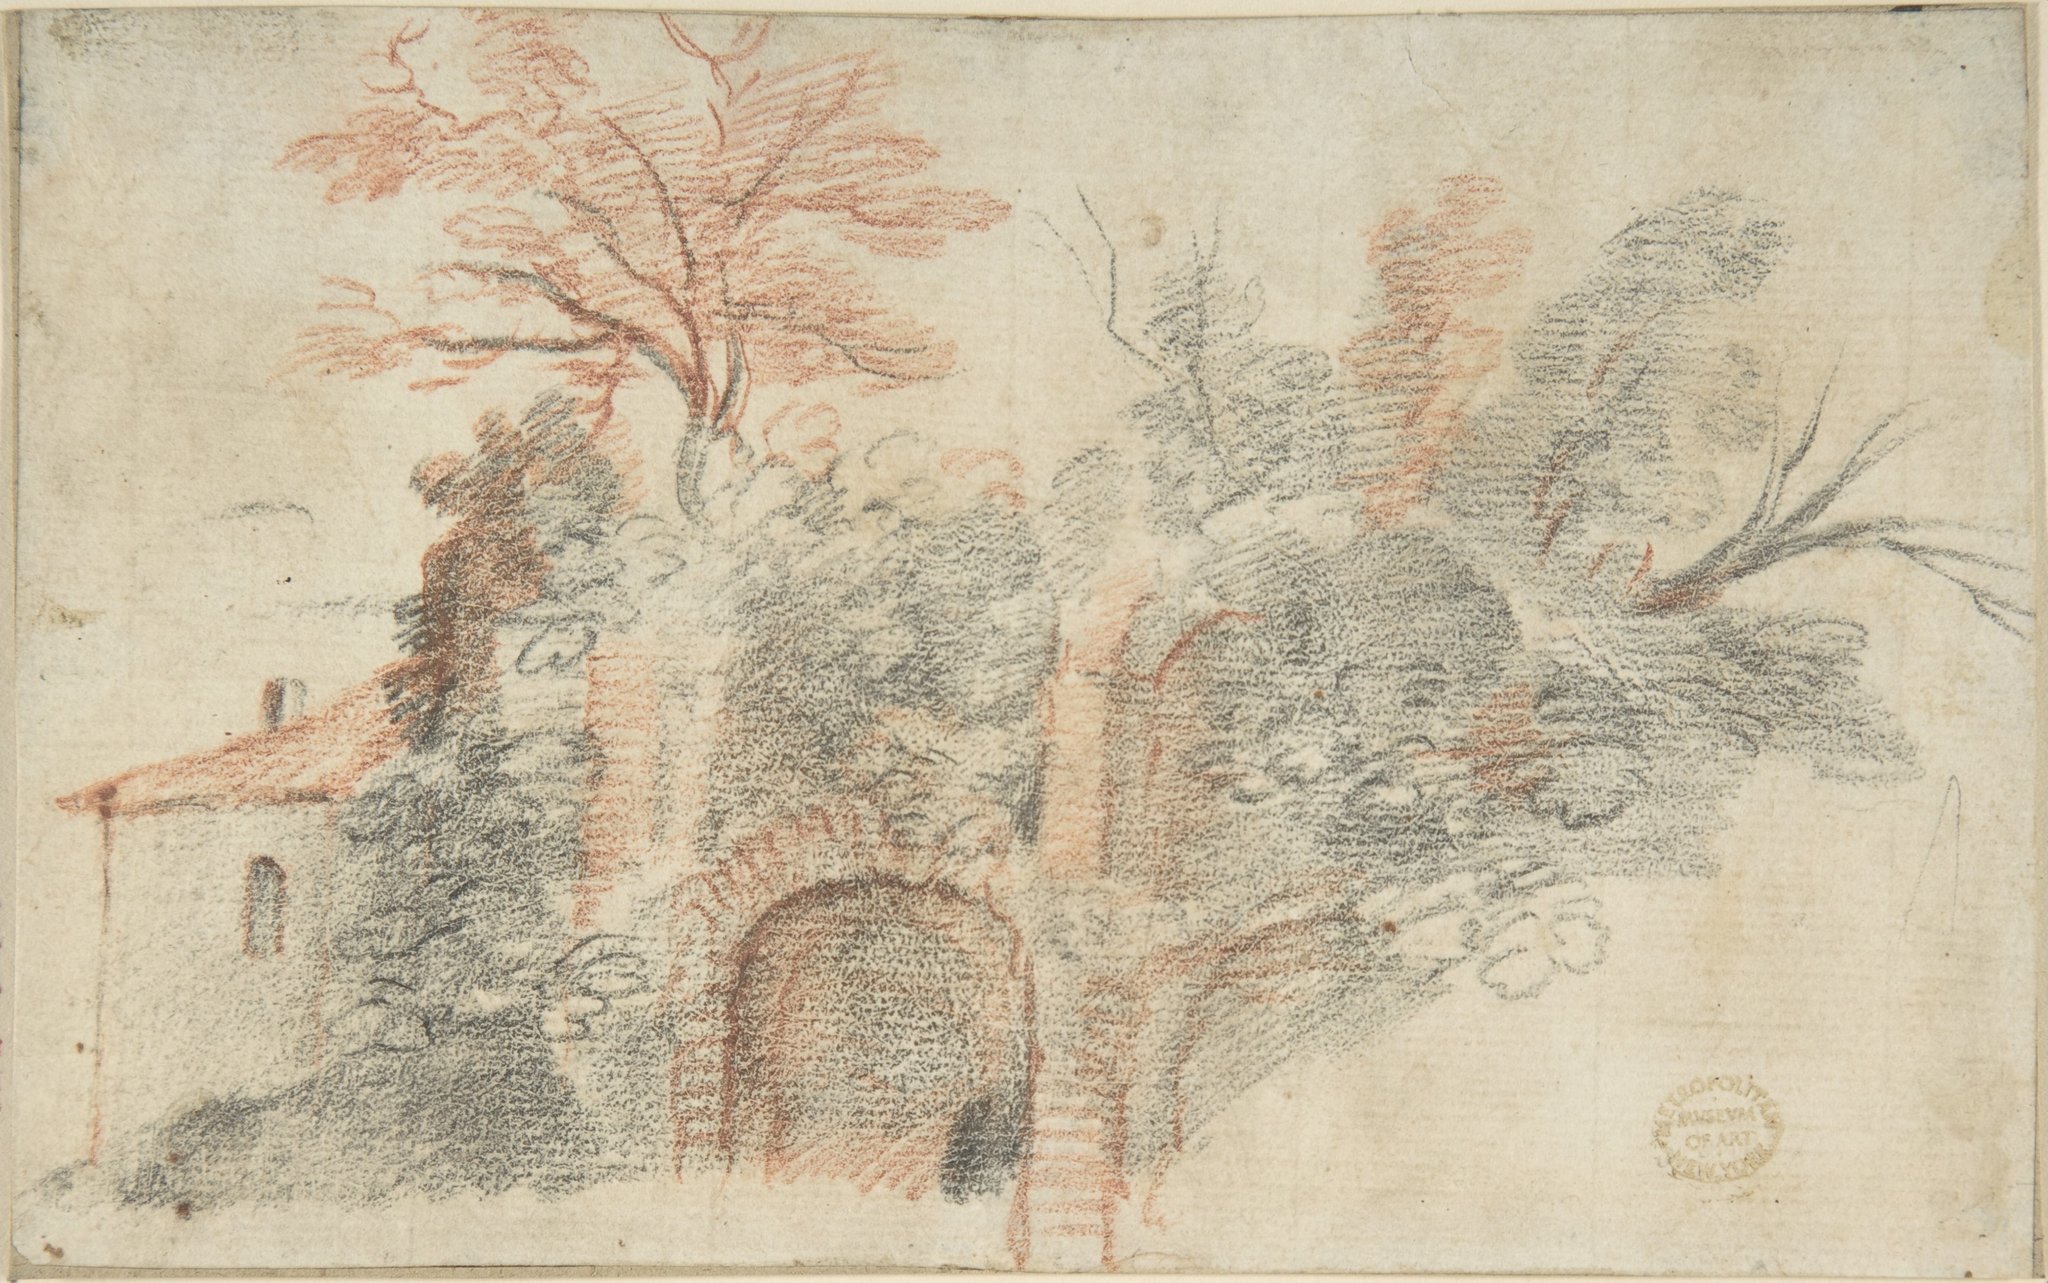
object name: drawing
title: Ruins and Trees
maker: anonymous, italian, roman-bolognese, 17th century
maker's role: artist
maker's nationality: italian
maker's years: 1600-1700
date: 1601-1700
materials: chalk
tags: ruins,trees